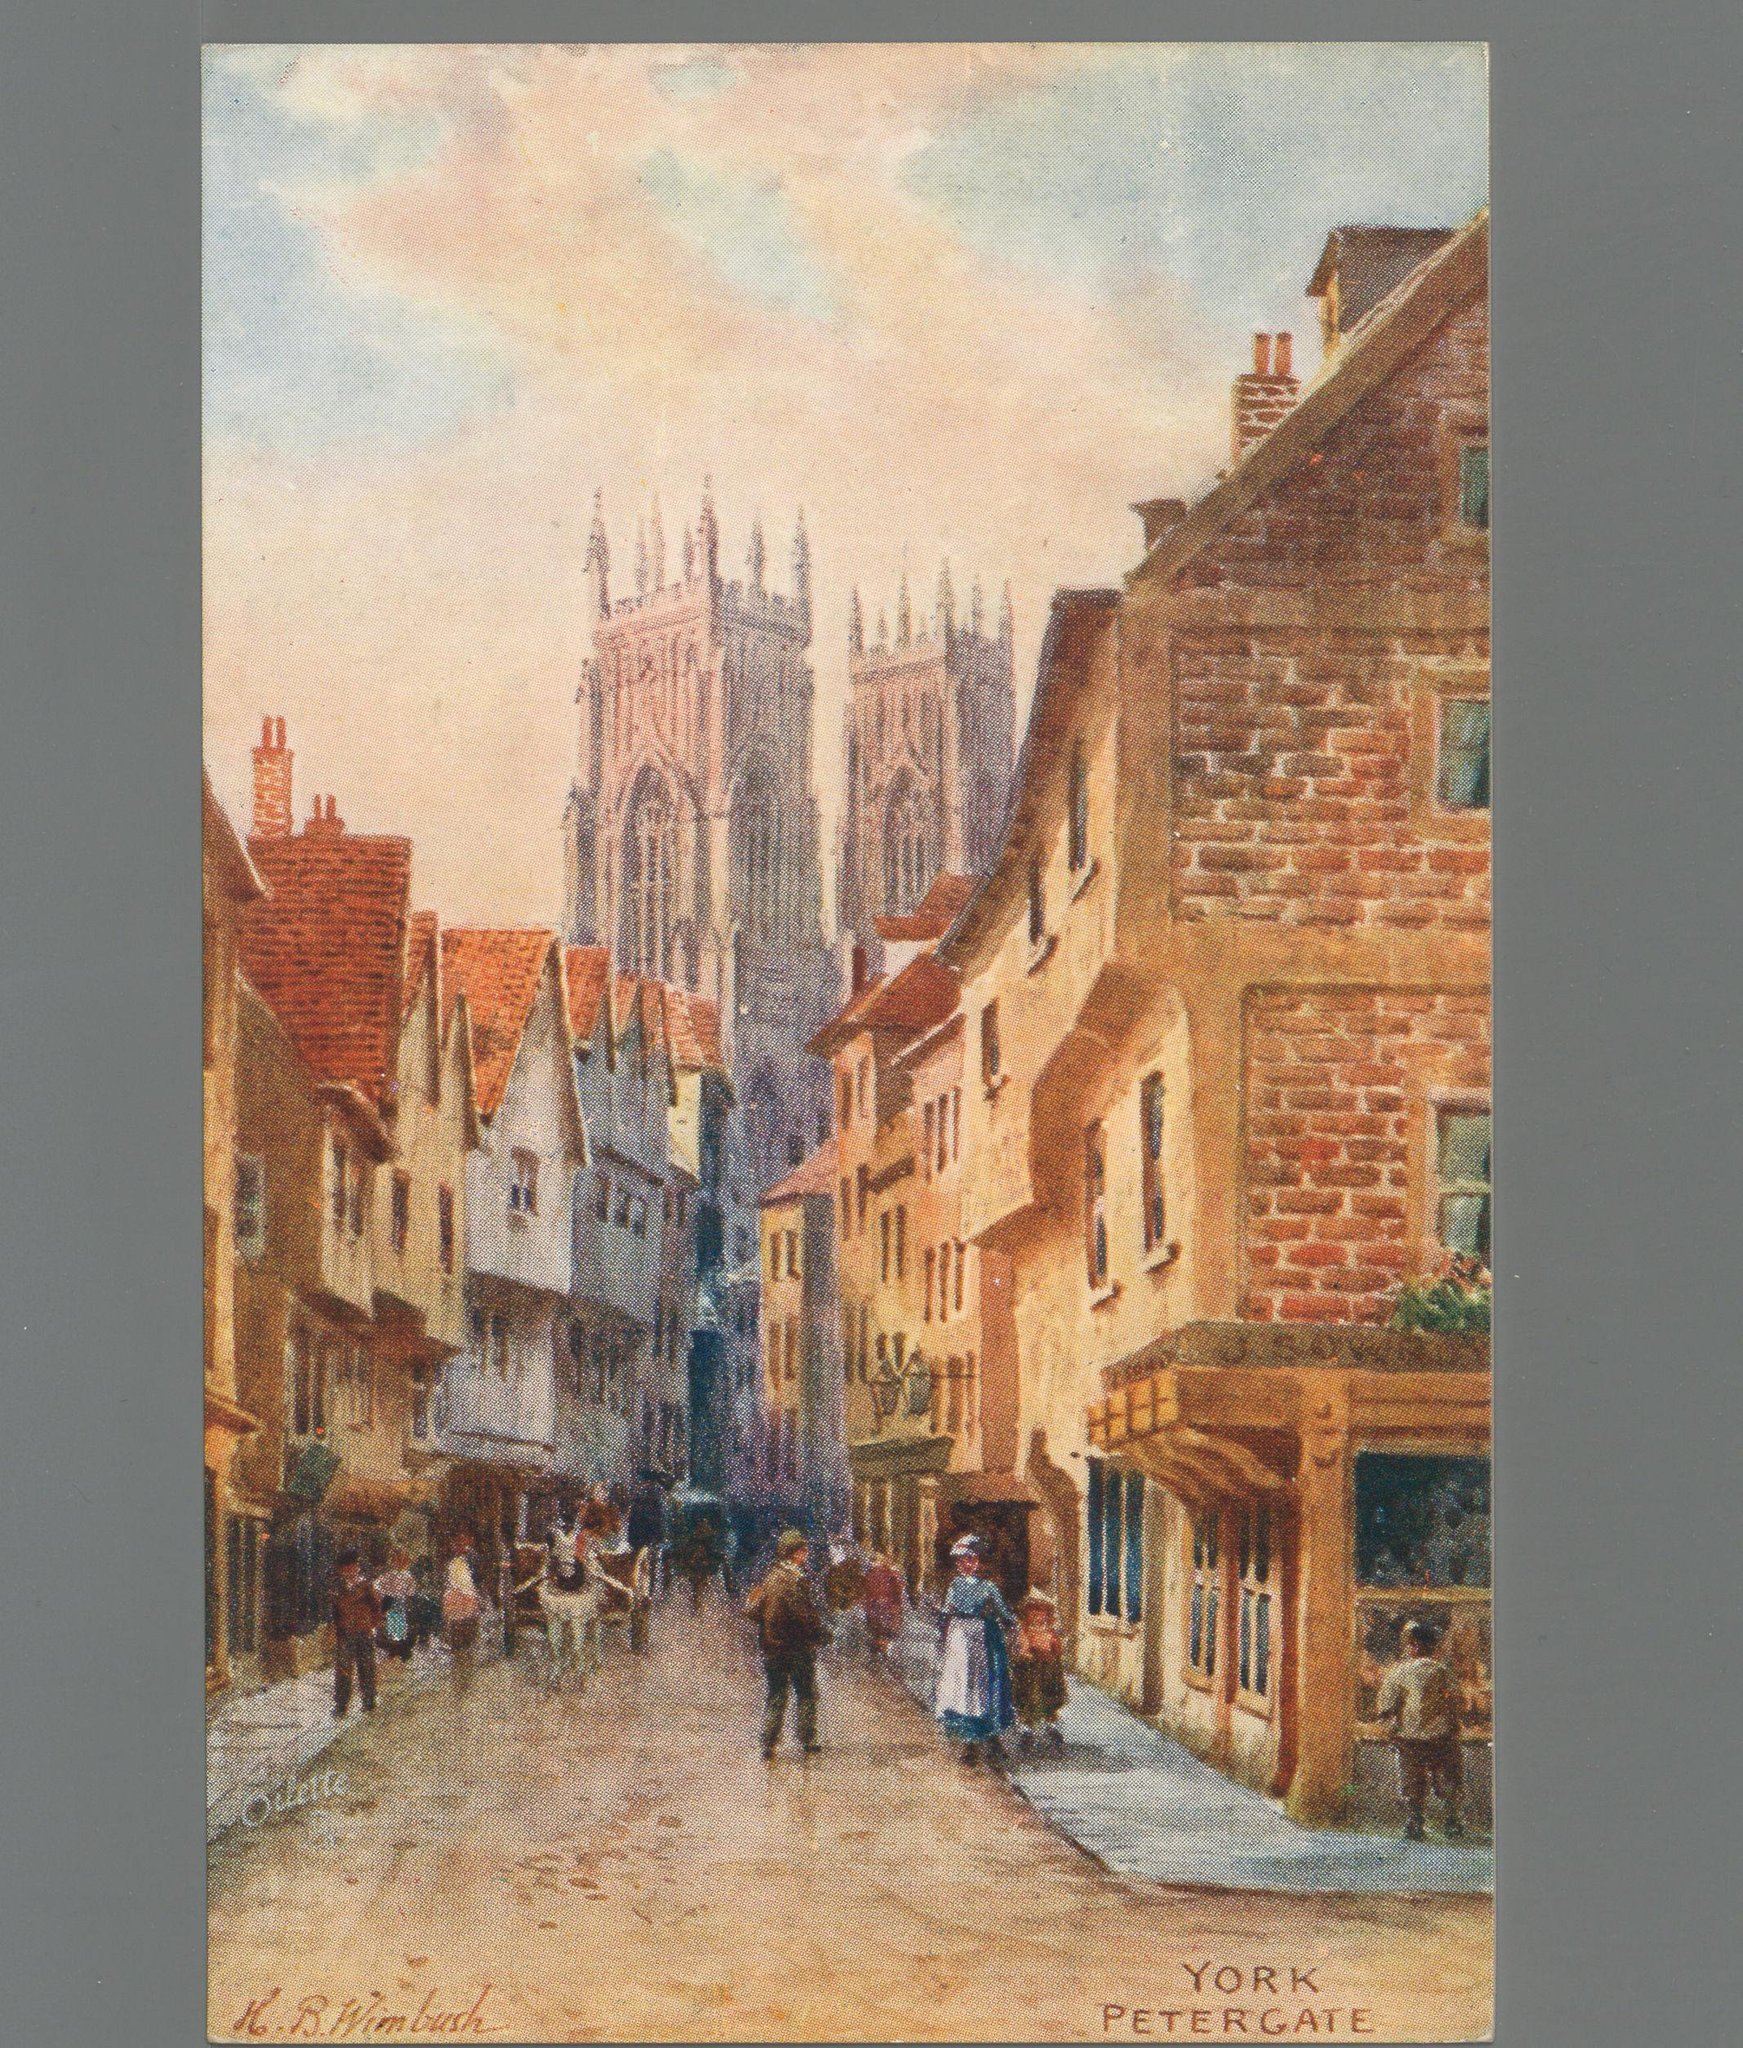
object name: ansichtkaart, prentbriefkaart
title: York. Petergate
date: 1908-1930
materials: cardboard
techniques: color autotype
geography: england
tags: church (exterior), street